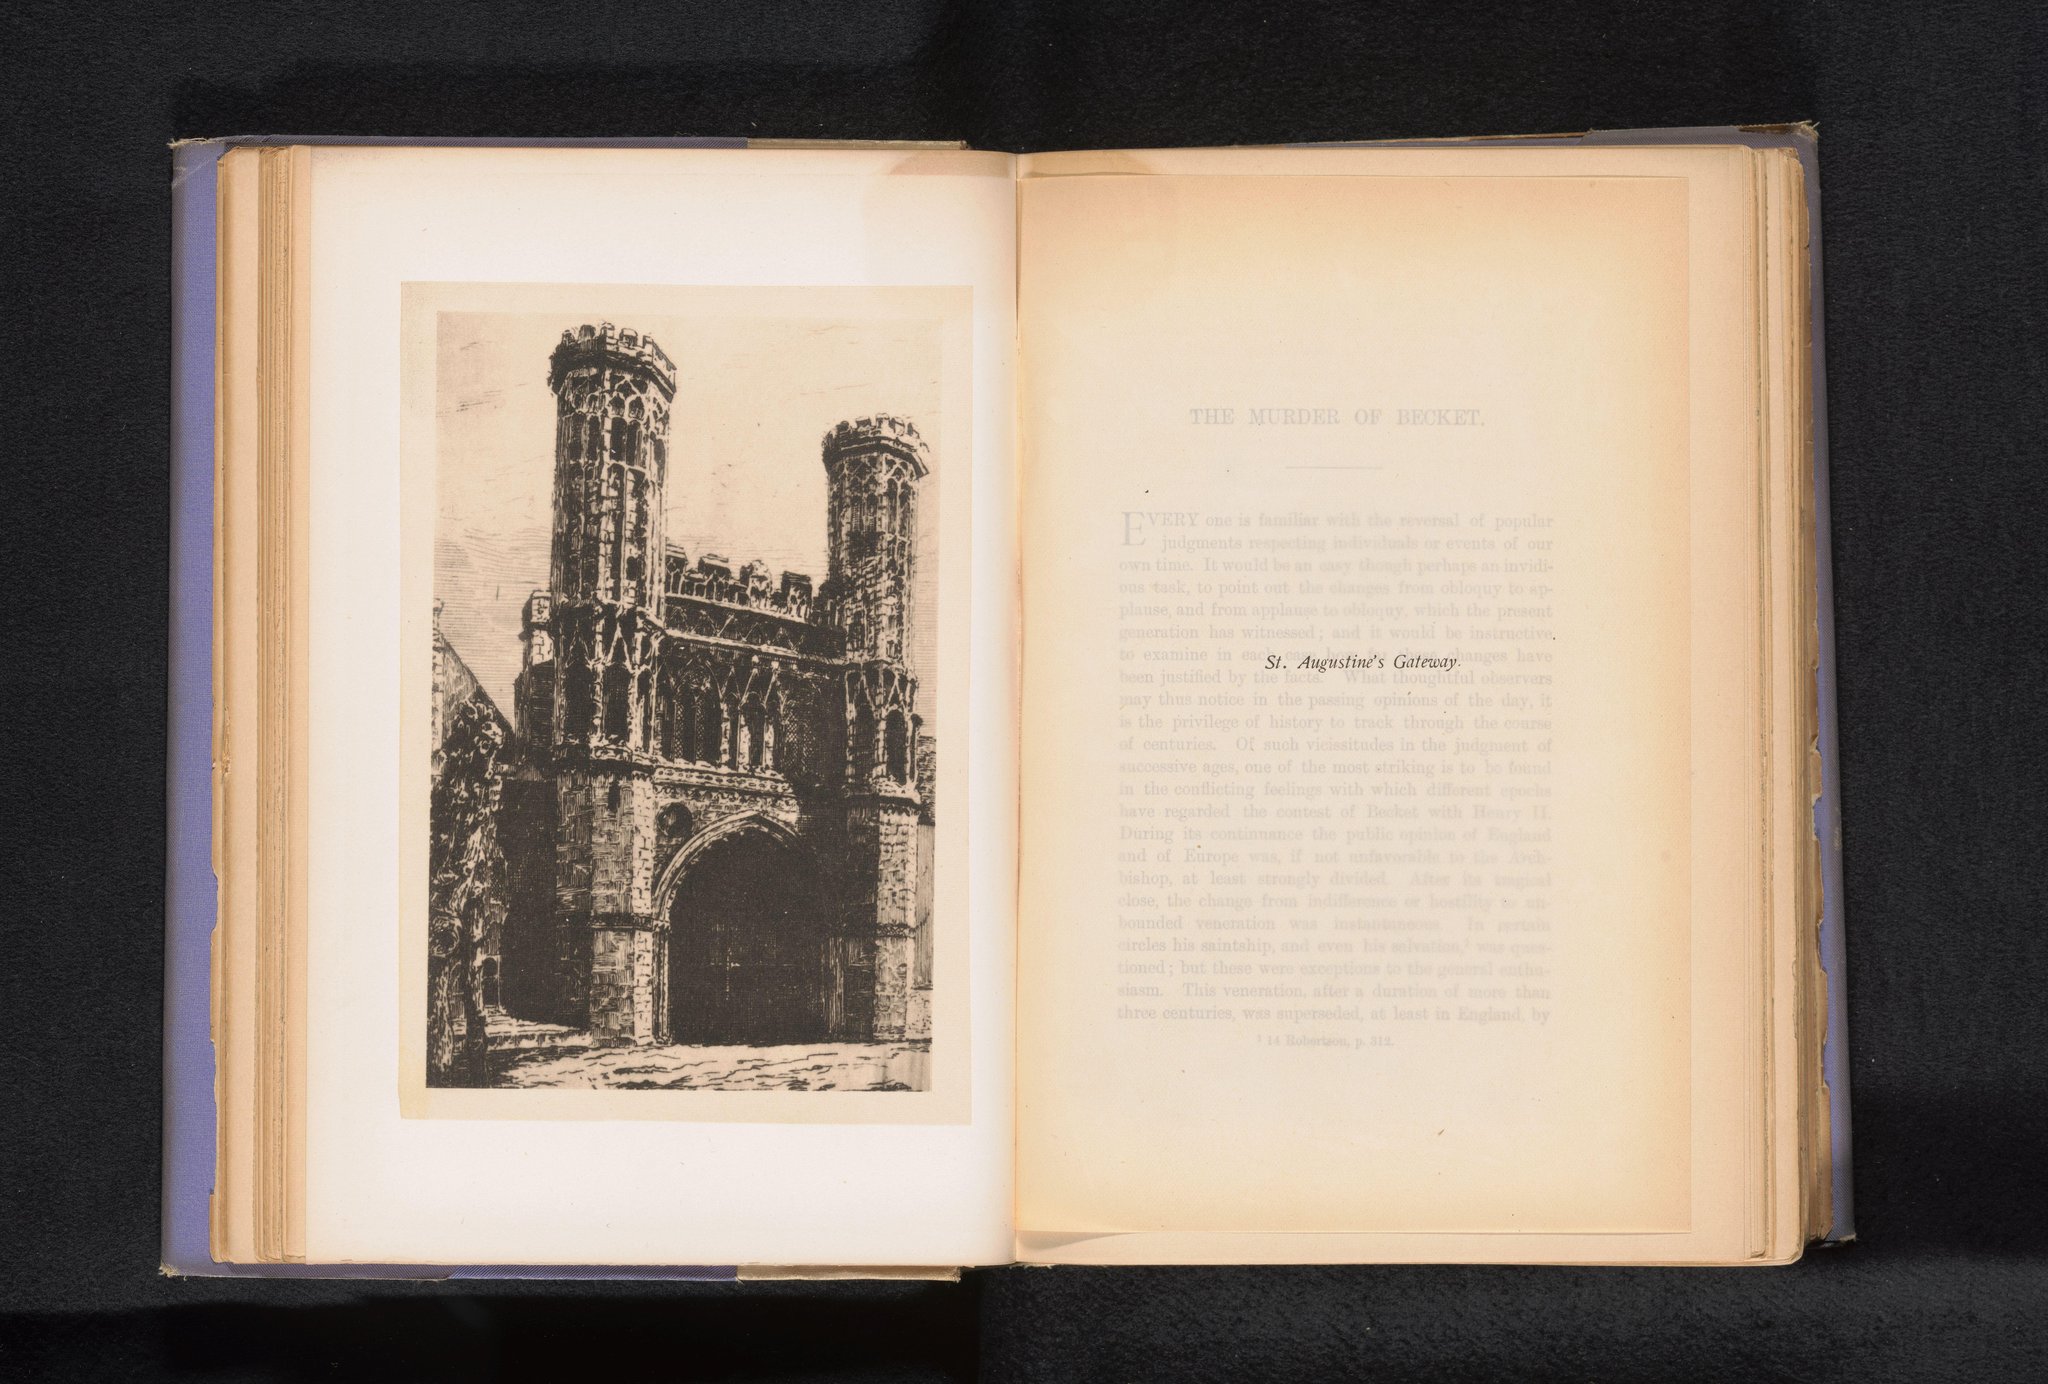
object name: reproduction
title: St. Augustine's Gateway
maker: Anonymous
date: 1882-1892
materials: paper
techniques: photograph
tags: church (exterior), gate, entrance